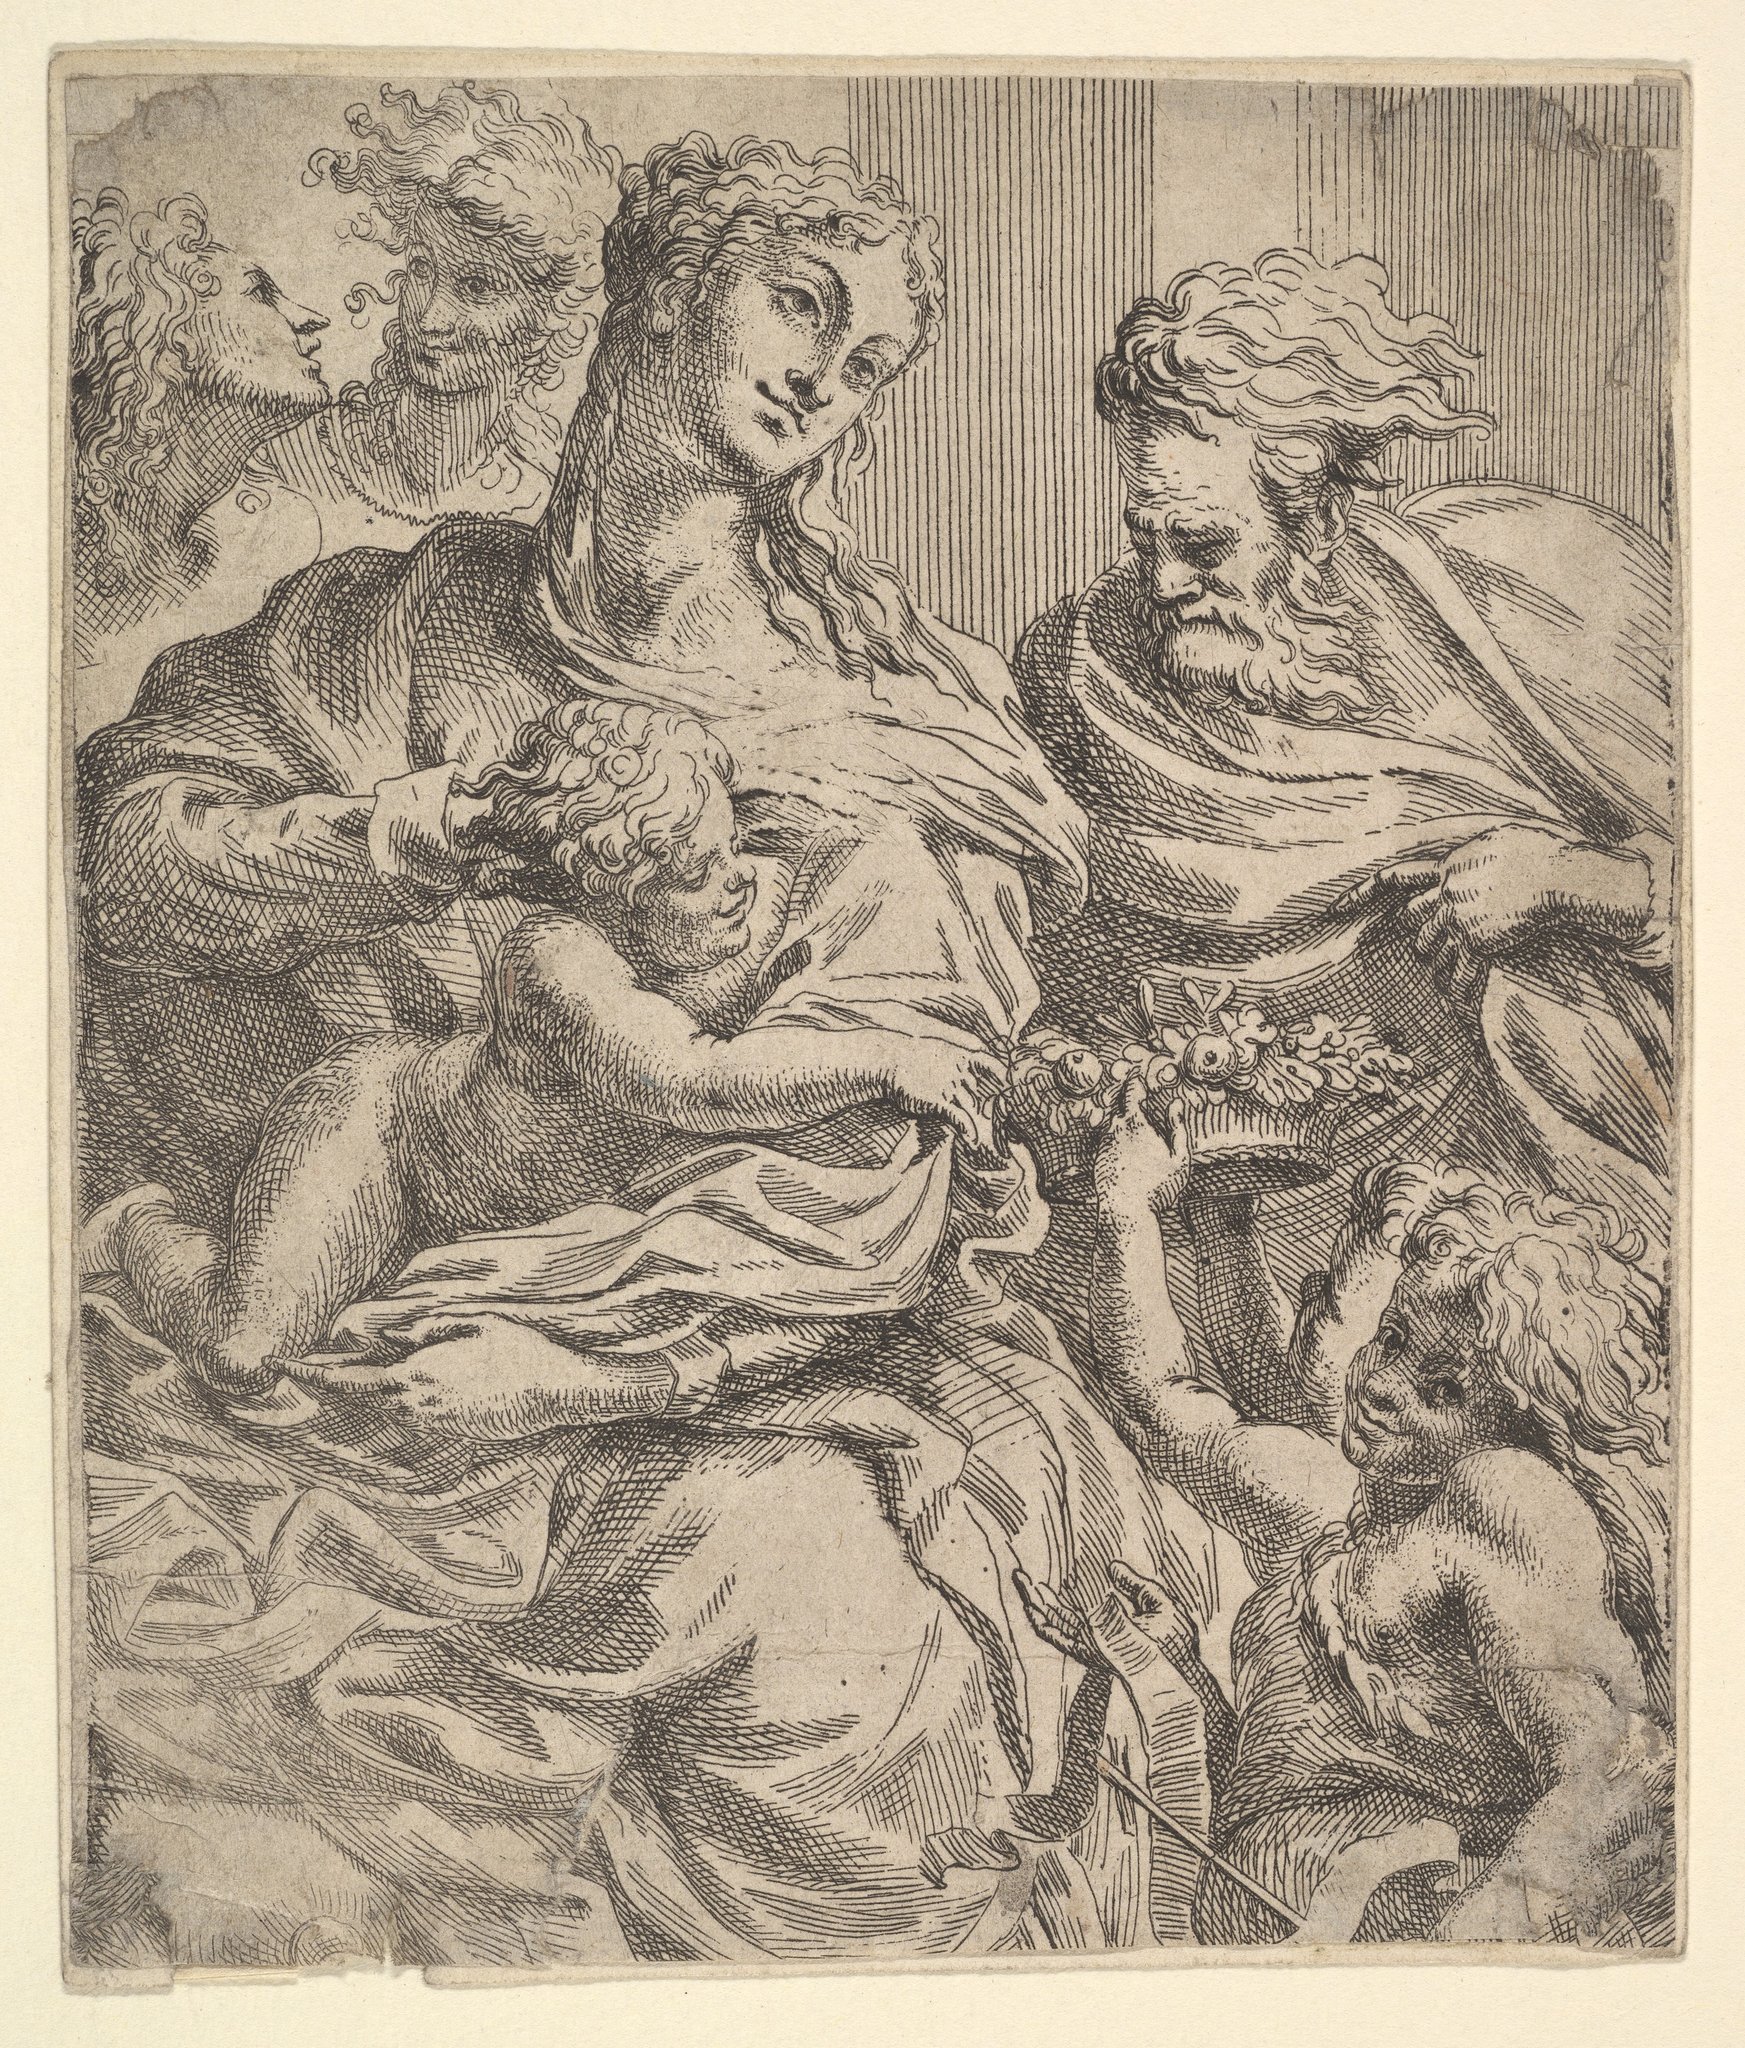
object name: print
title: Holy Family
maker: anonymous, italian, 17th century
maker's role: artist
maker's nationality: italian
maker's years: 1600-1700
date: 1601-1700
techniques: etching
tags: christ,holy family,virgin mary